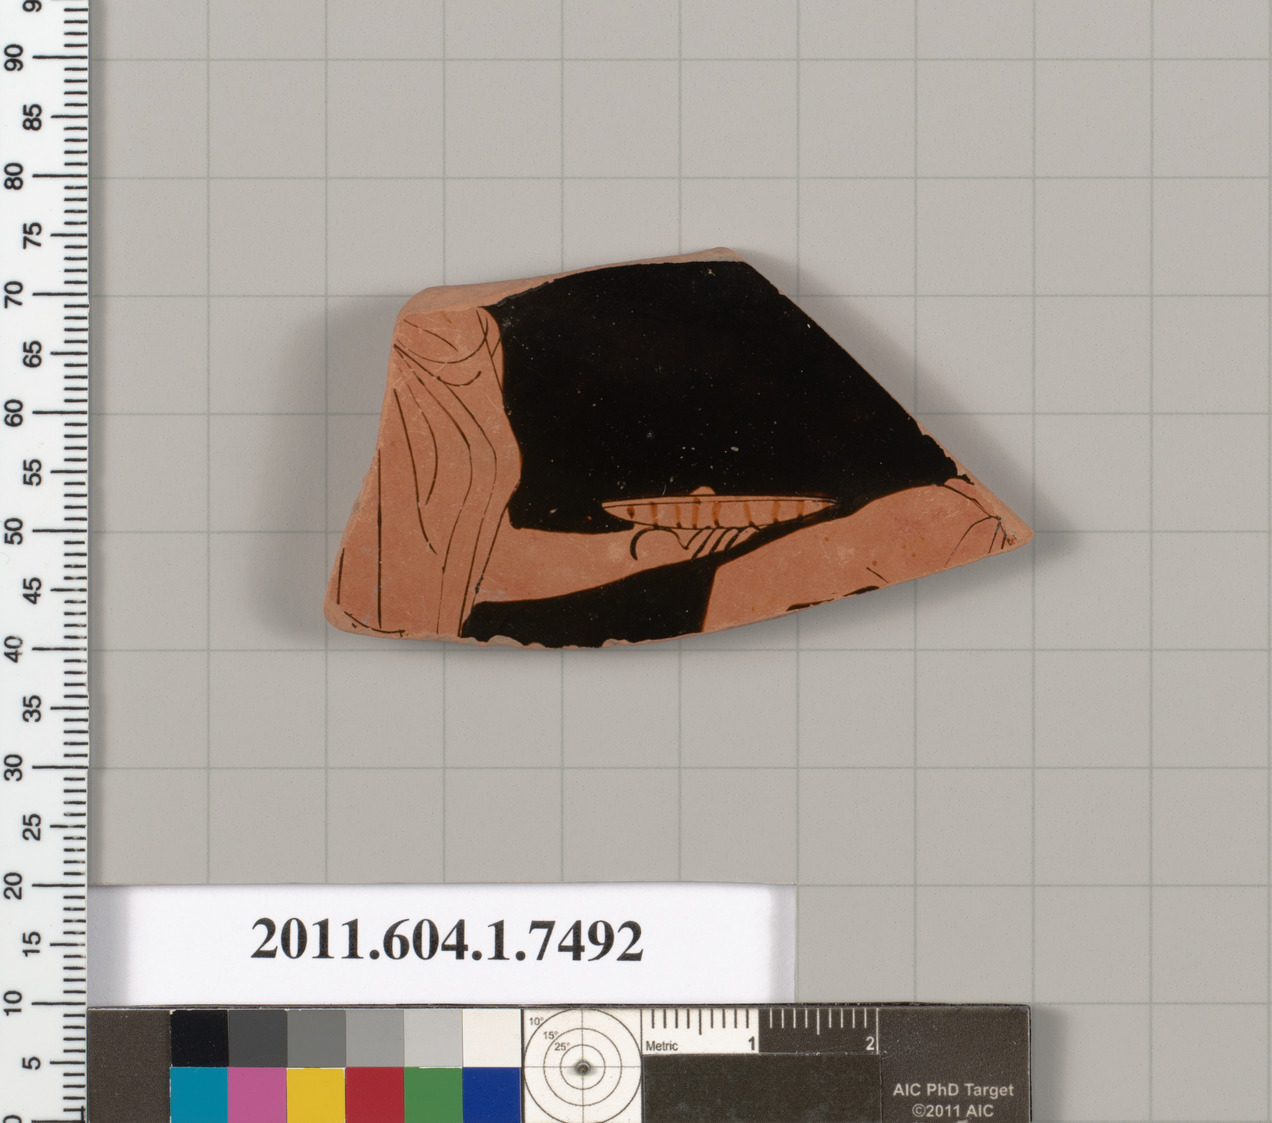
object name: kylix fragment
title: Terracotta fragment of a kylix (drinking cup)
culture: greek, attic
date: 460-450 BCE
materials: terracotta